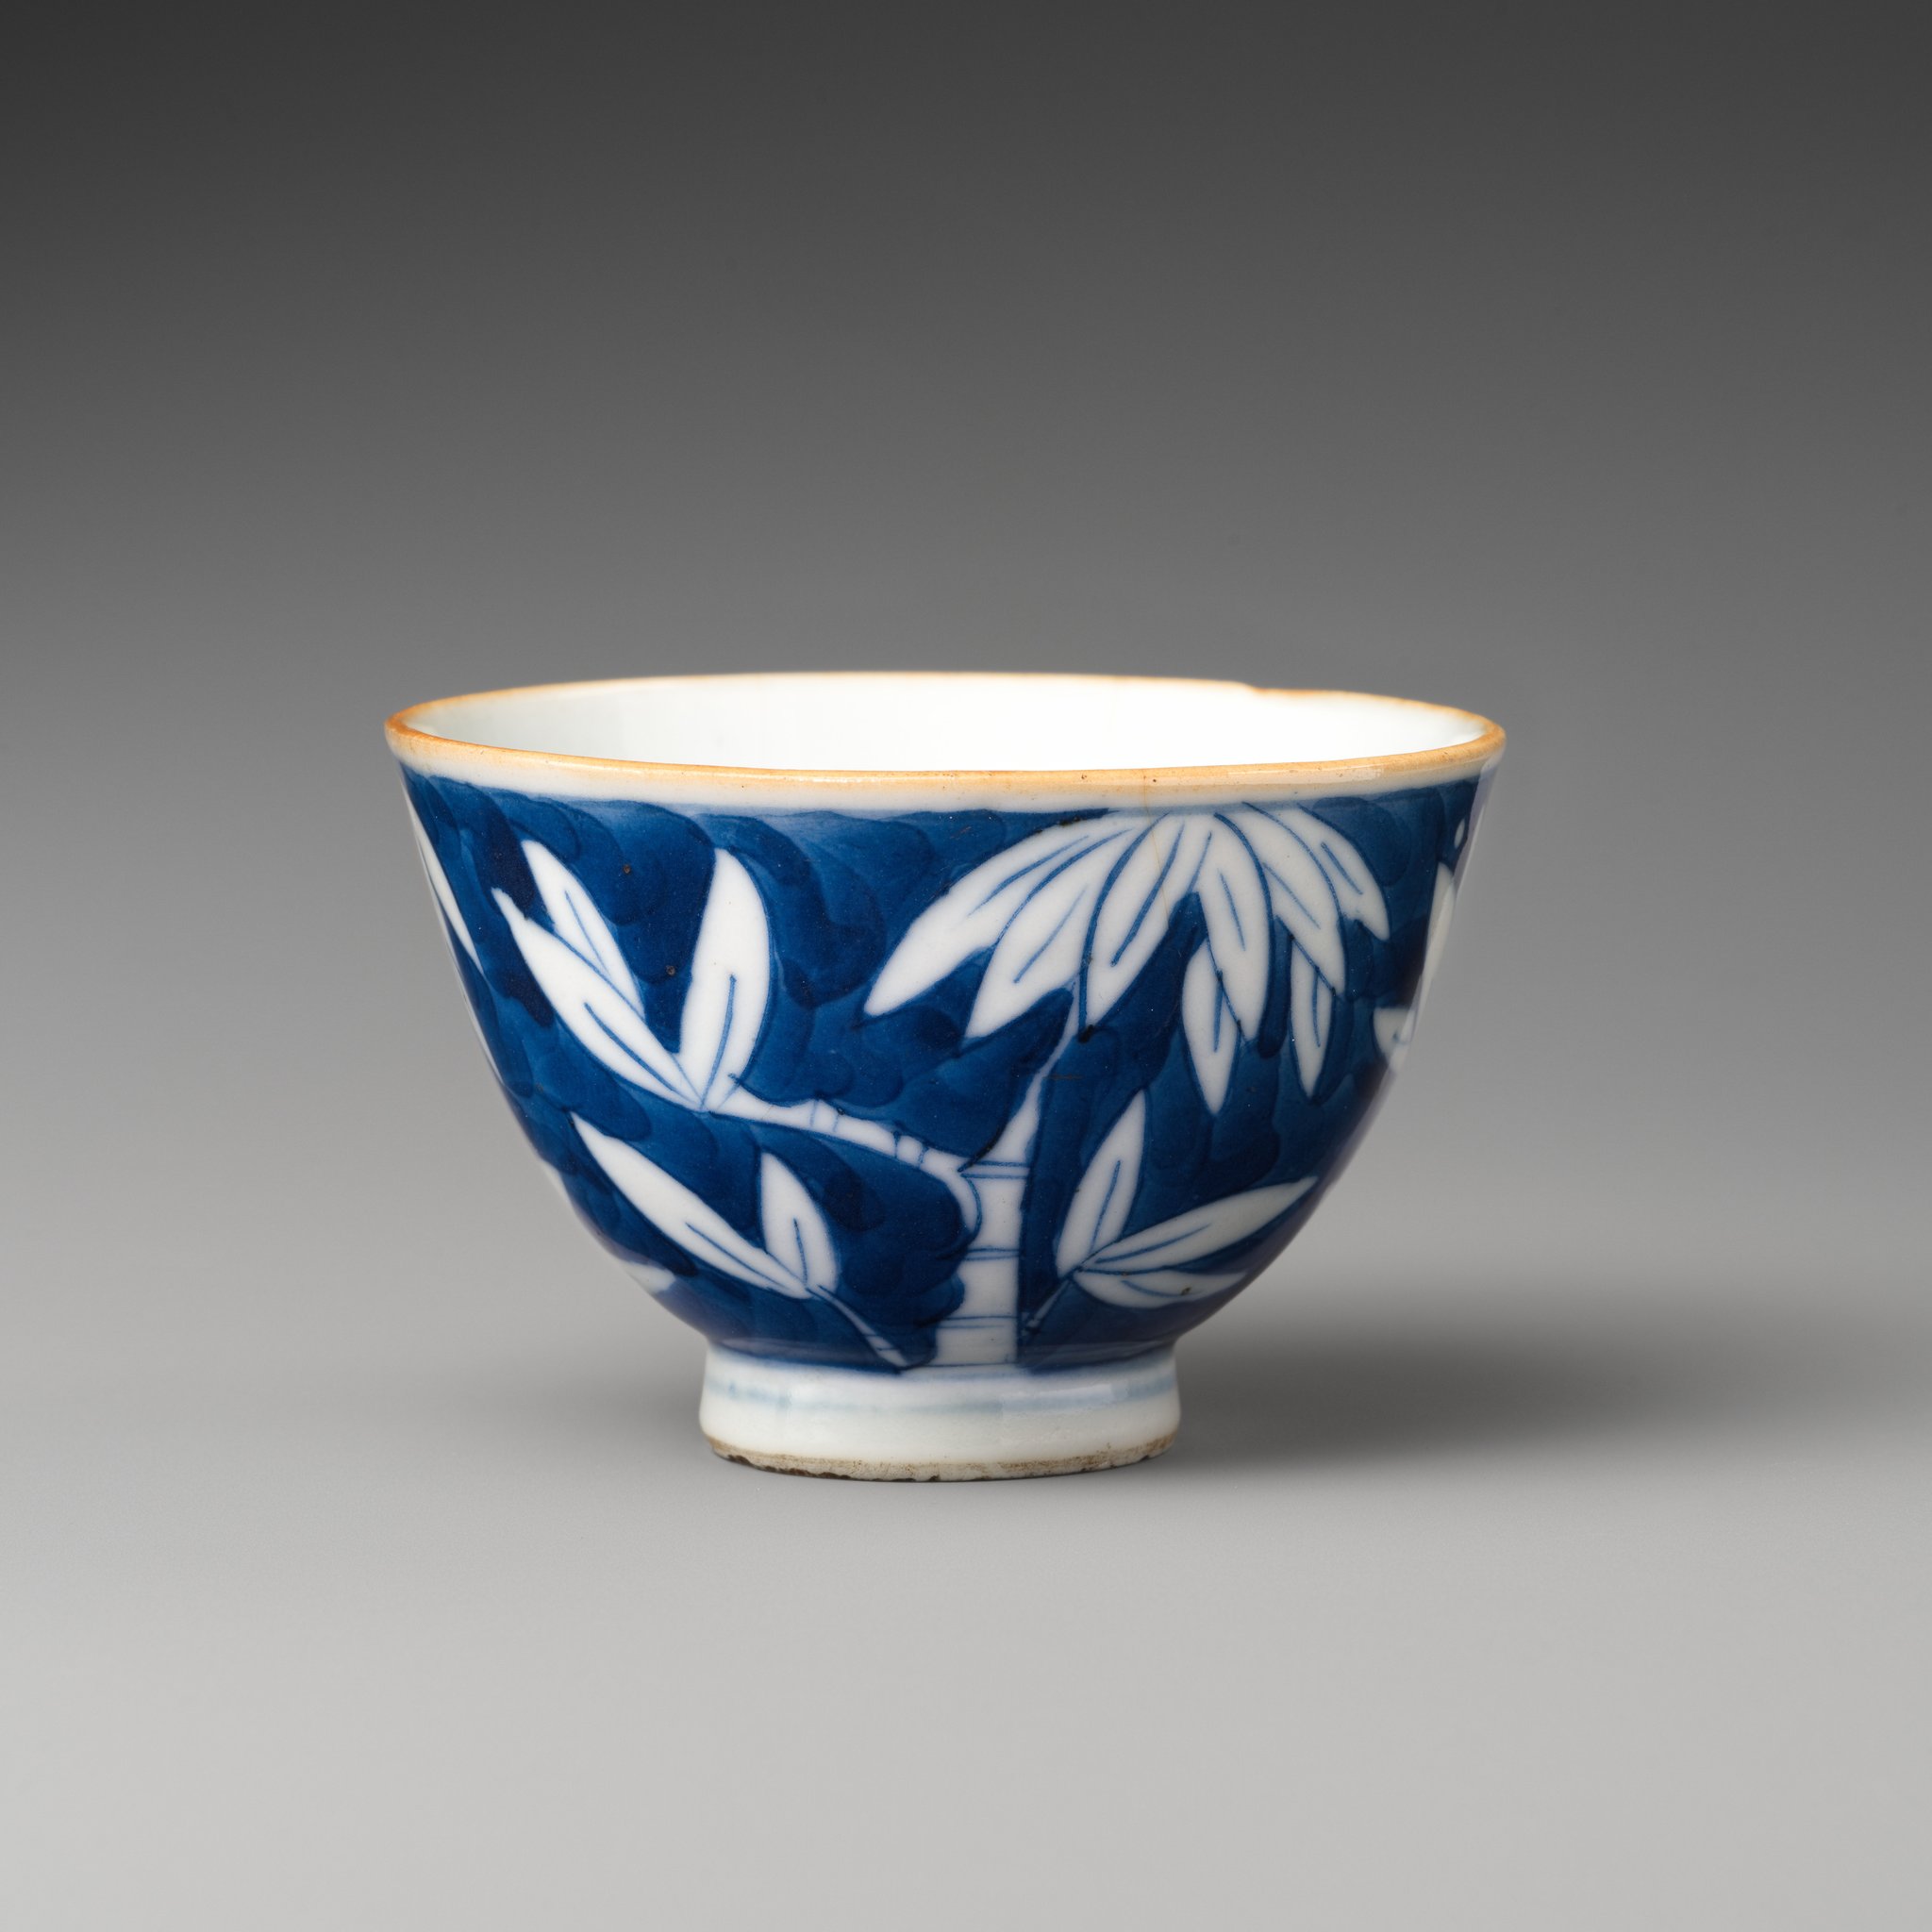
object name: cup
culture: japanese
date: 1800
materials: porcelain